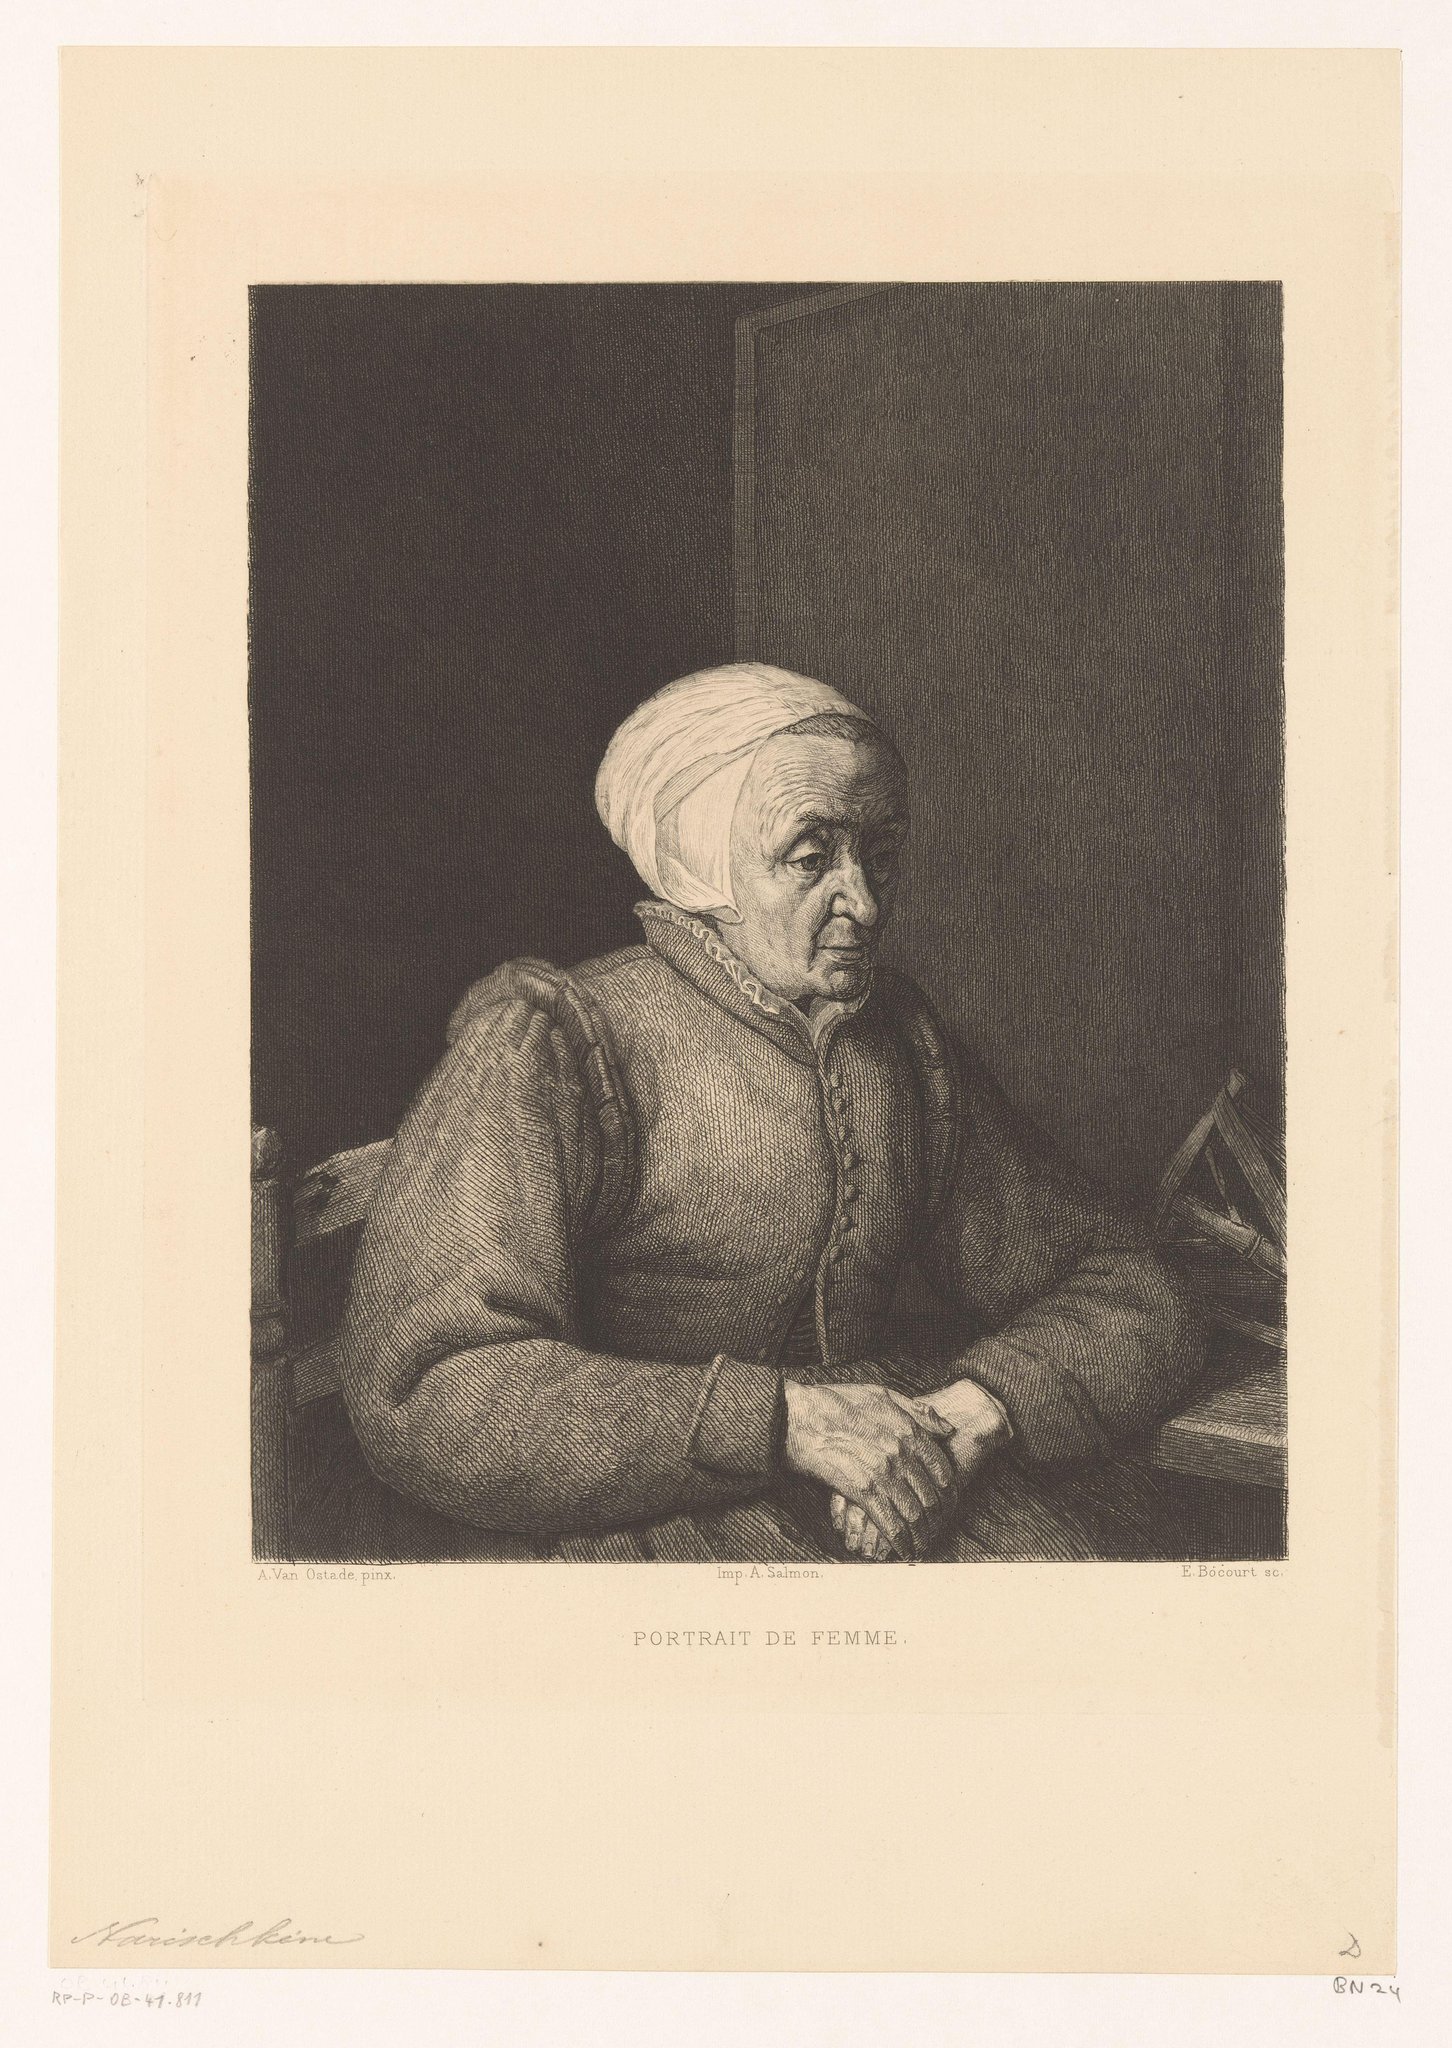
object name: print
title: Portret van een oude vrouw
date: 1863-1882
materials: paper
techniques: drypoint, etching, intaglio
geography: paris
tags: historical persons, old woman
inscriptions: collector's mark: Lugt 2228